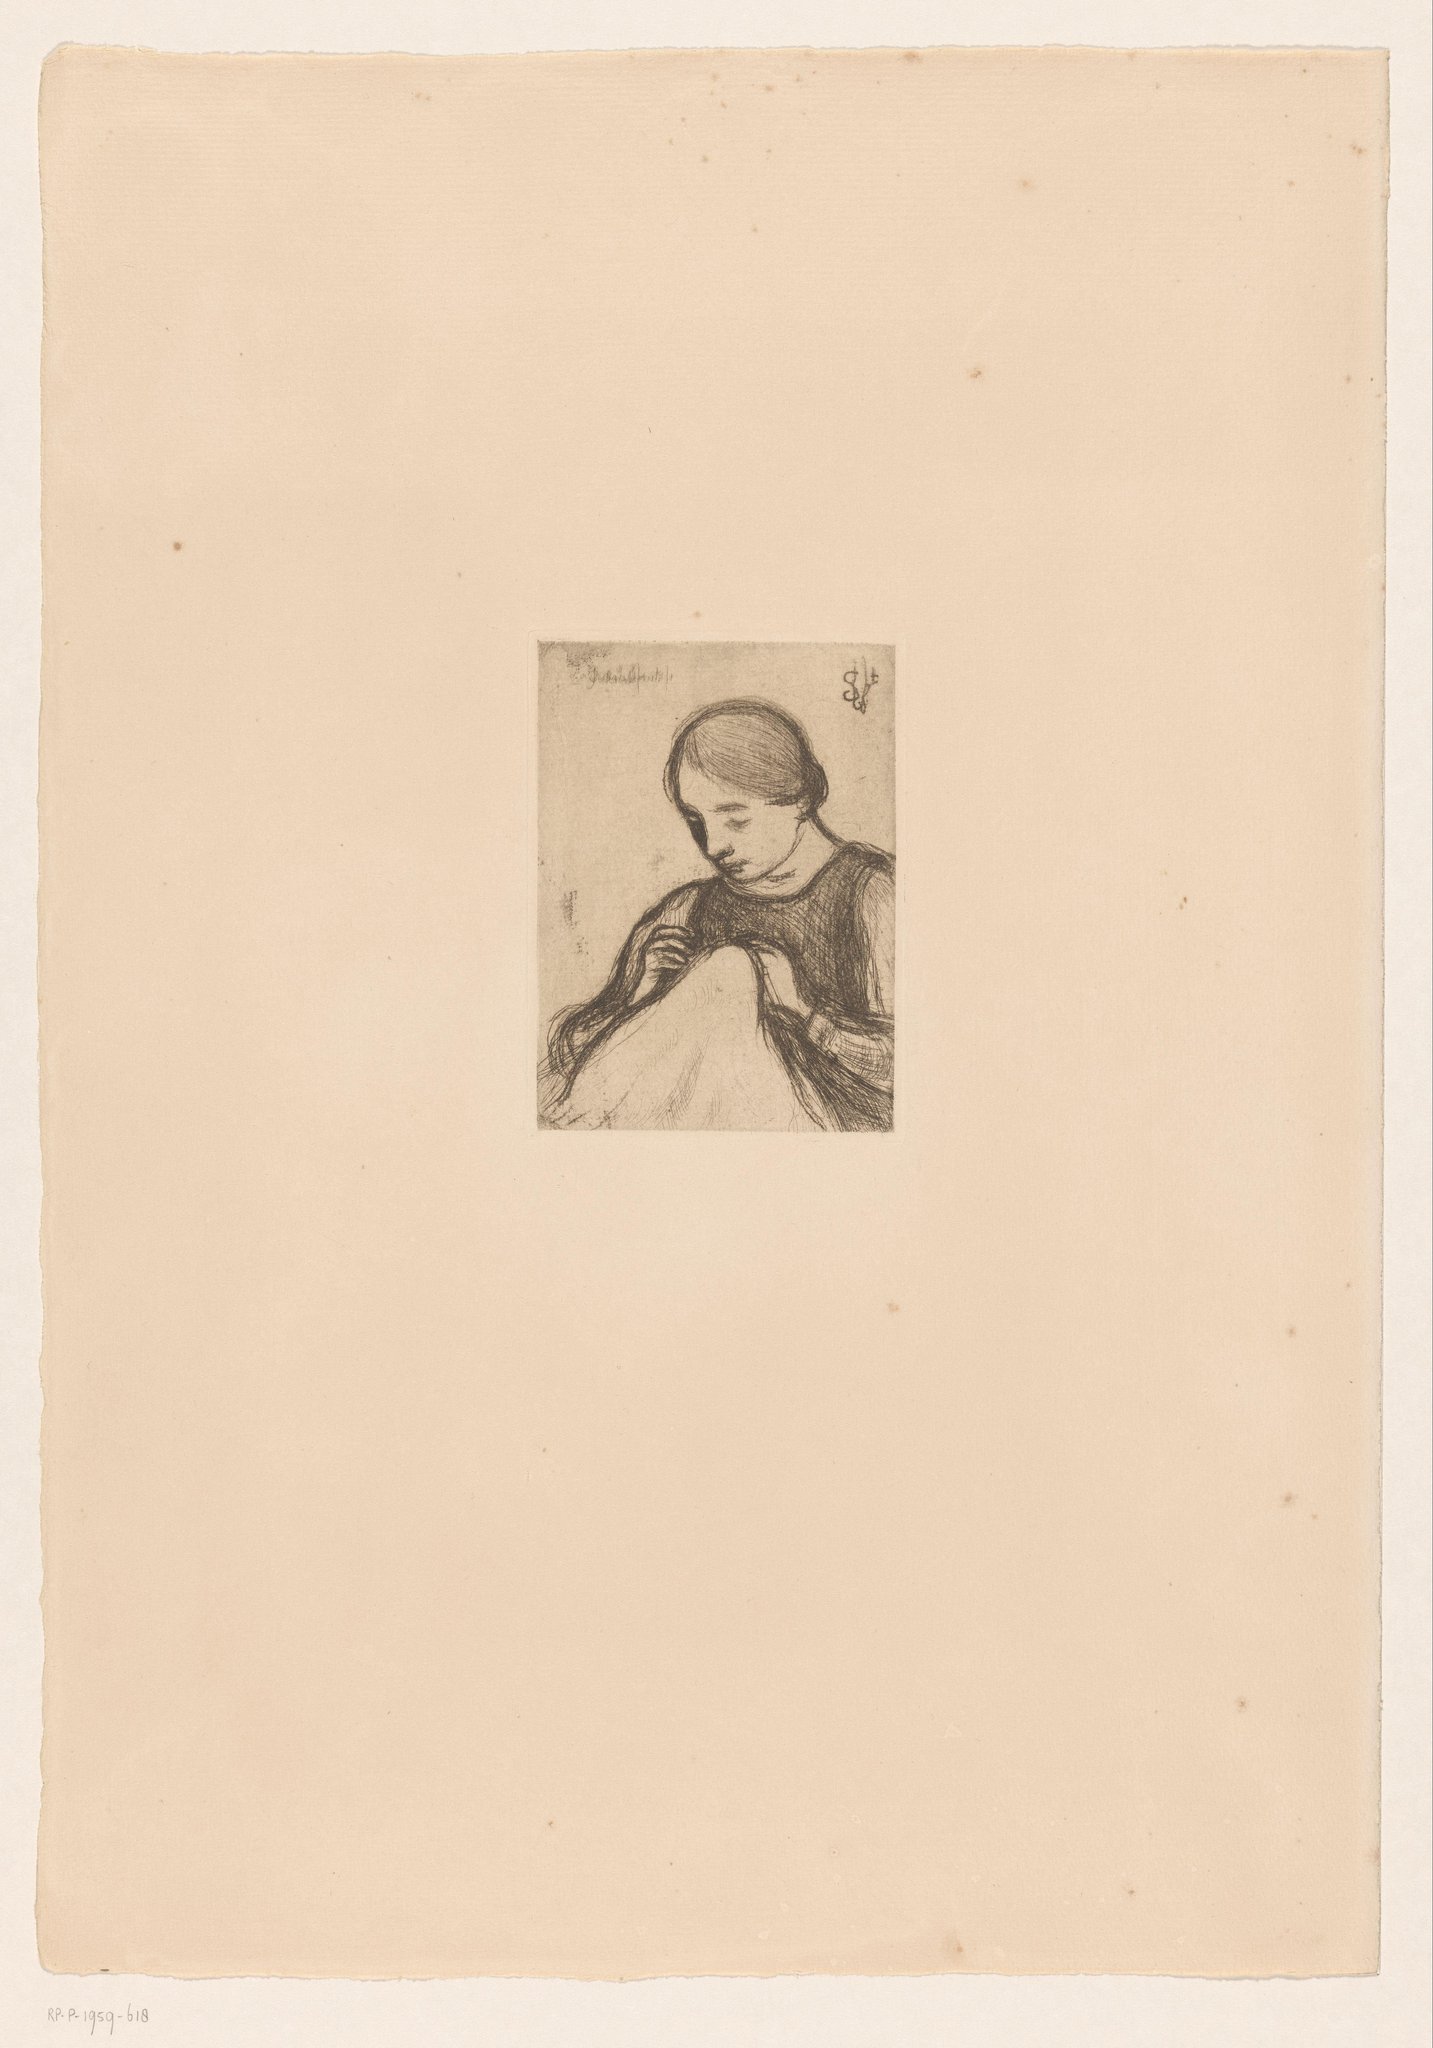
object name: print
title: Portret van Malvina Dedeyn met handwerk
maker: jakob smits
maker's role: draughtsman, print maker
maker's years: 1855-1928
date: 1903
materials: paper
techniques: etching, soft ground etching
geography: netherlands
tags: brussels, historical persons - bb - woman, (other forms of) needlework, e.g.: crocheting, knitting, embroidering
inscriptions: collector's mark: Lugt 2760, collector's mark: Lugt 2228